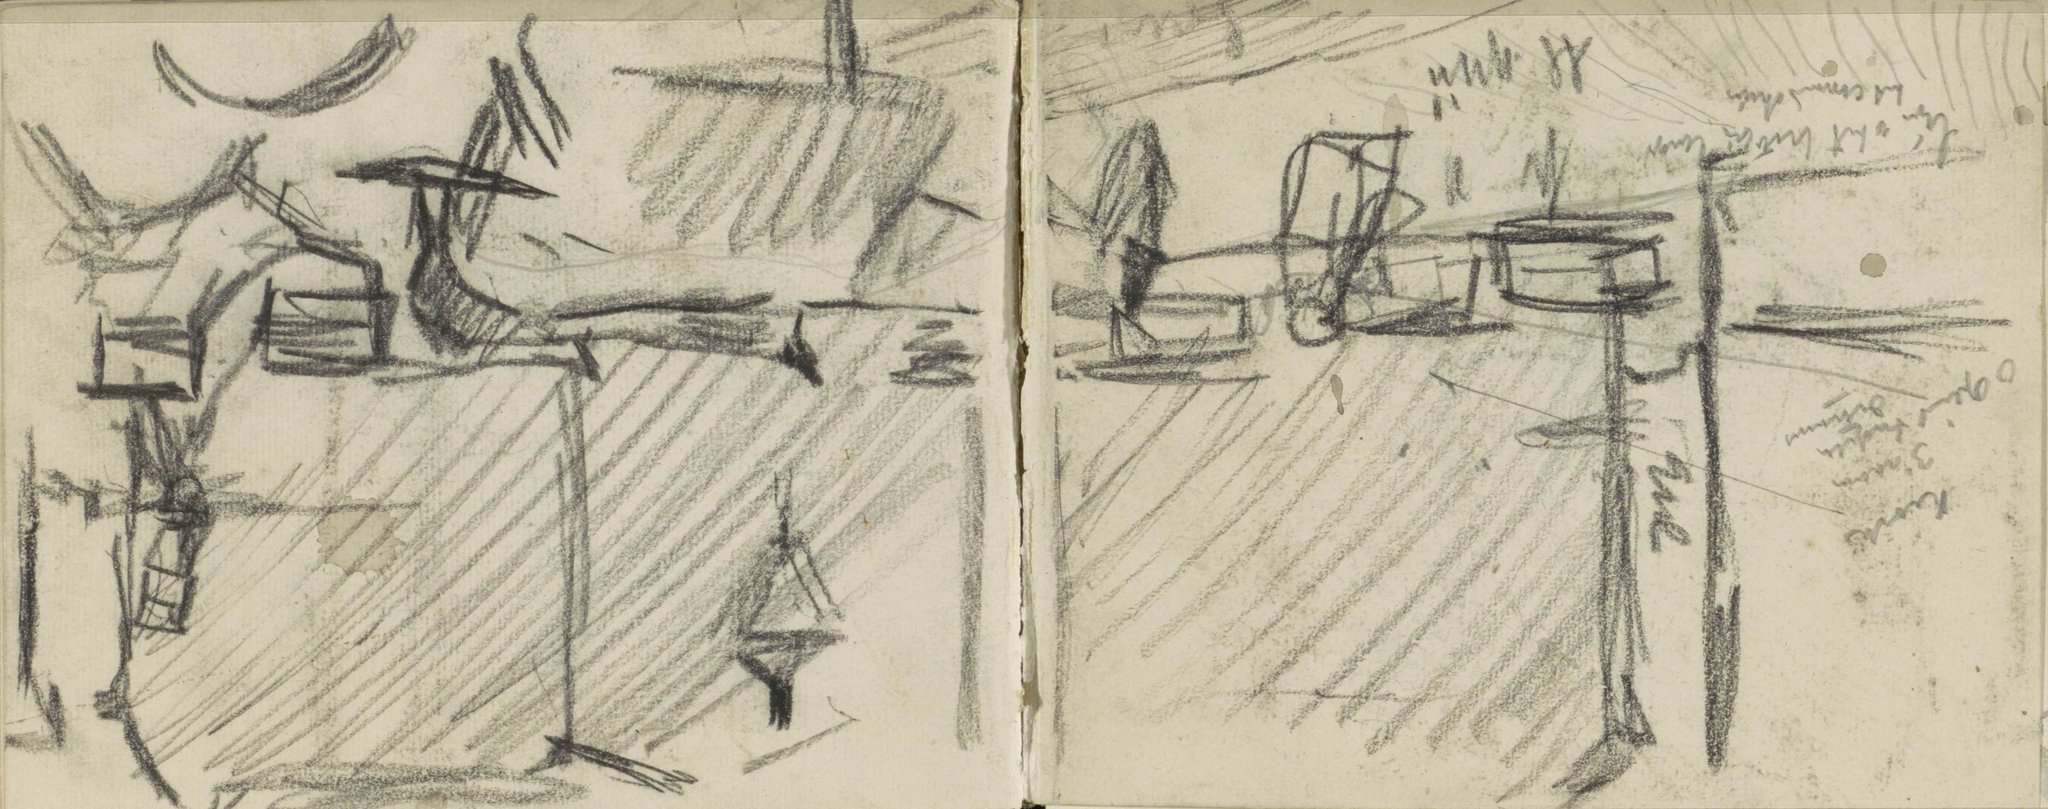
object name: sketchbook leaf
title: Rijtuig voor het Koninklijk Paleis op de Dam te Amsterdam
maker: george hendrik breitner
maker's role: draughtsman, painter, print maker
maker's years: 1857-1923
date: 1886-1903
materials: chalk, paper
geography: amsterdam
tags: diligence, omnibus, horse-tram, palace, square, place, circus, etc. (+ city(-scape) with figures, staffage), royal palace of amsterdam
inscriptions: kleurnotitie, handgeschreven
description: Gezien vanaf de Beurs van Zocher. Pagina 47 en pagina 48 uit een schetsboek met 32 bladen.